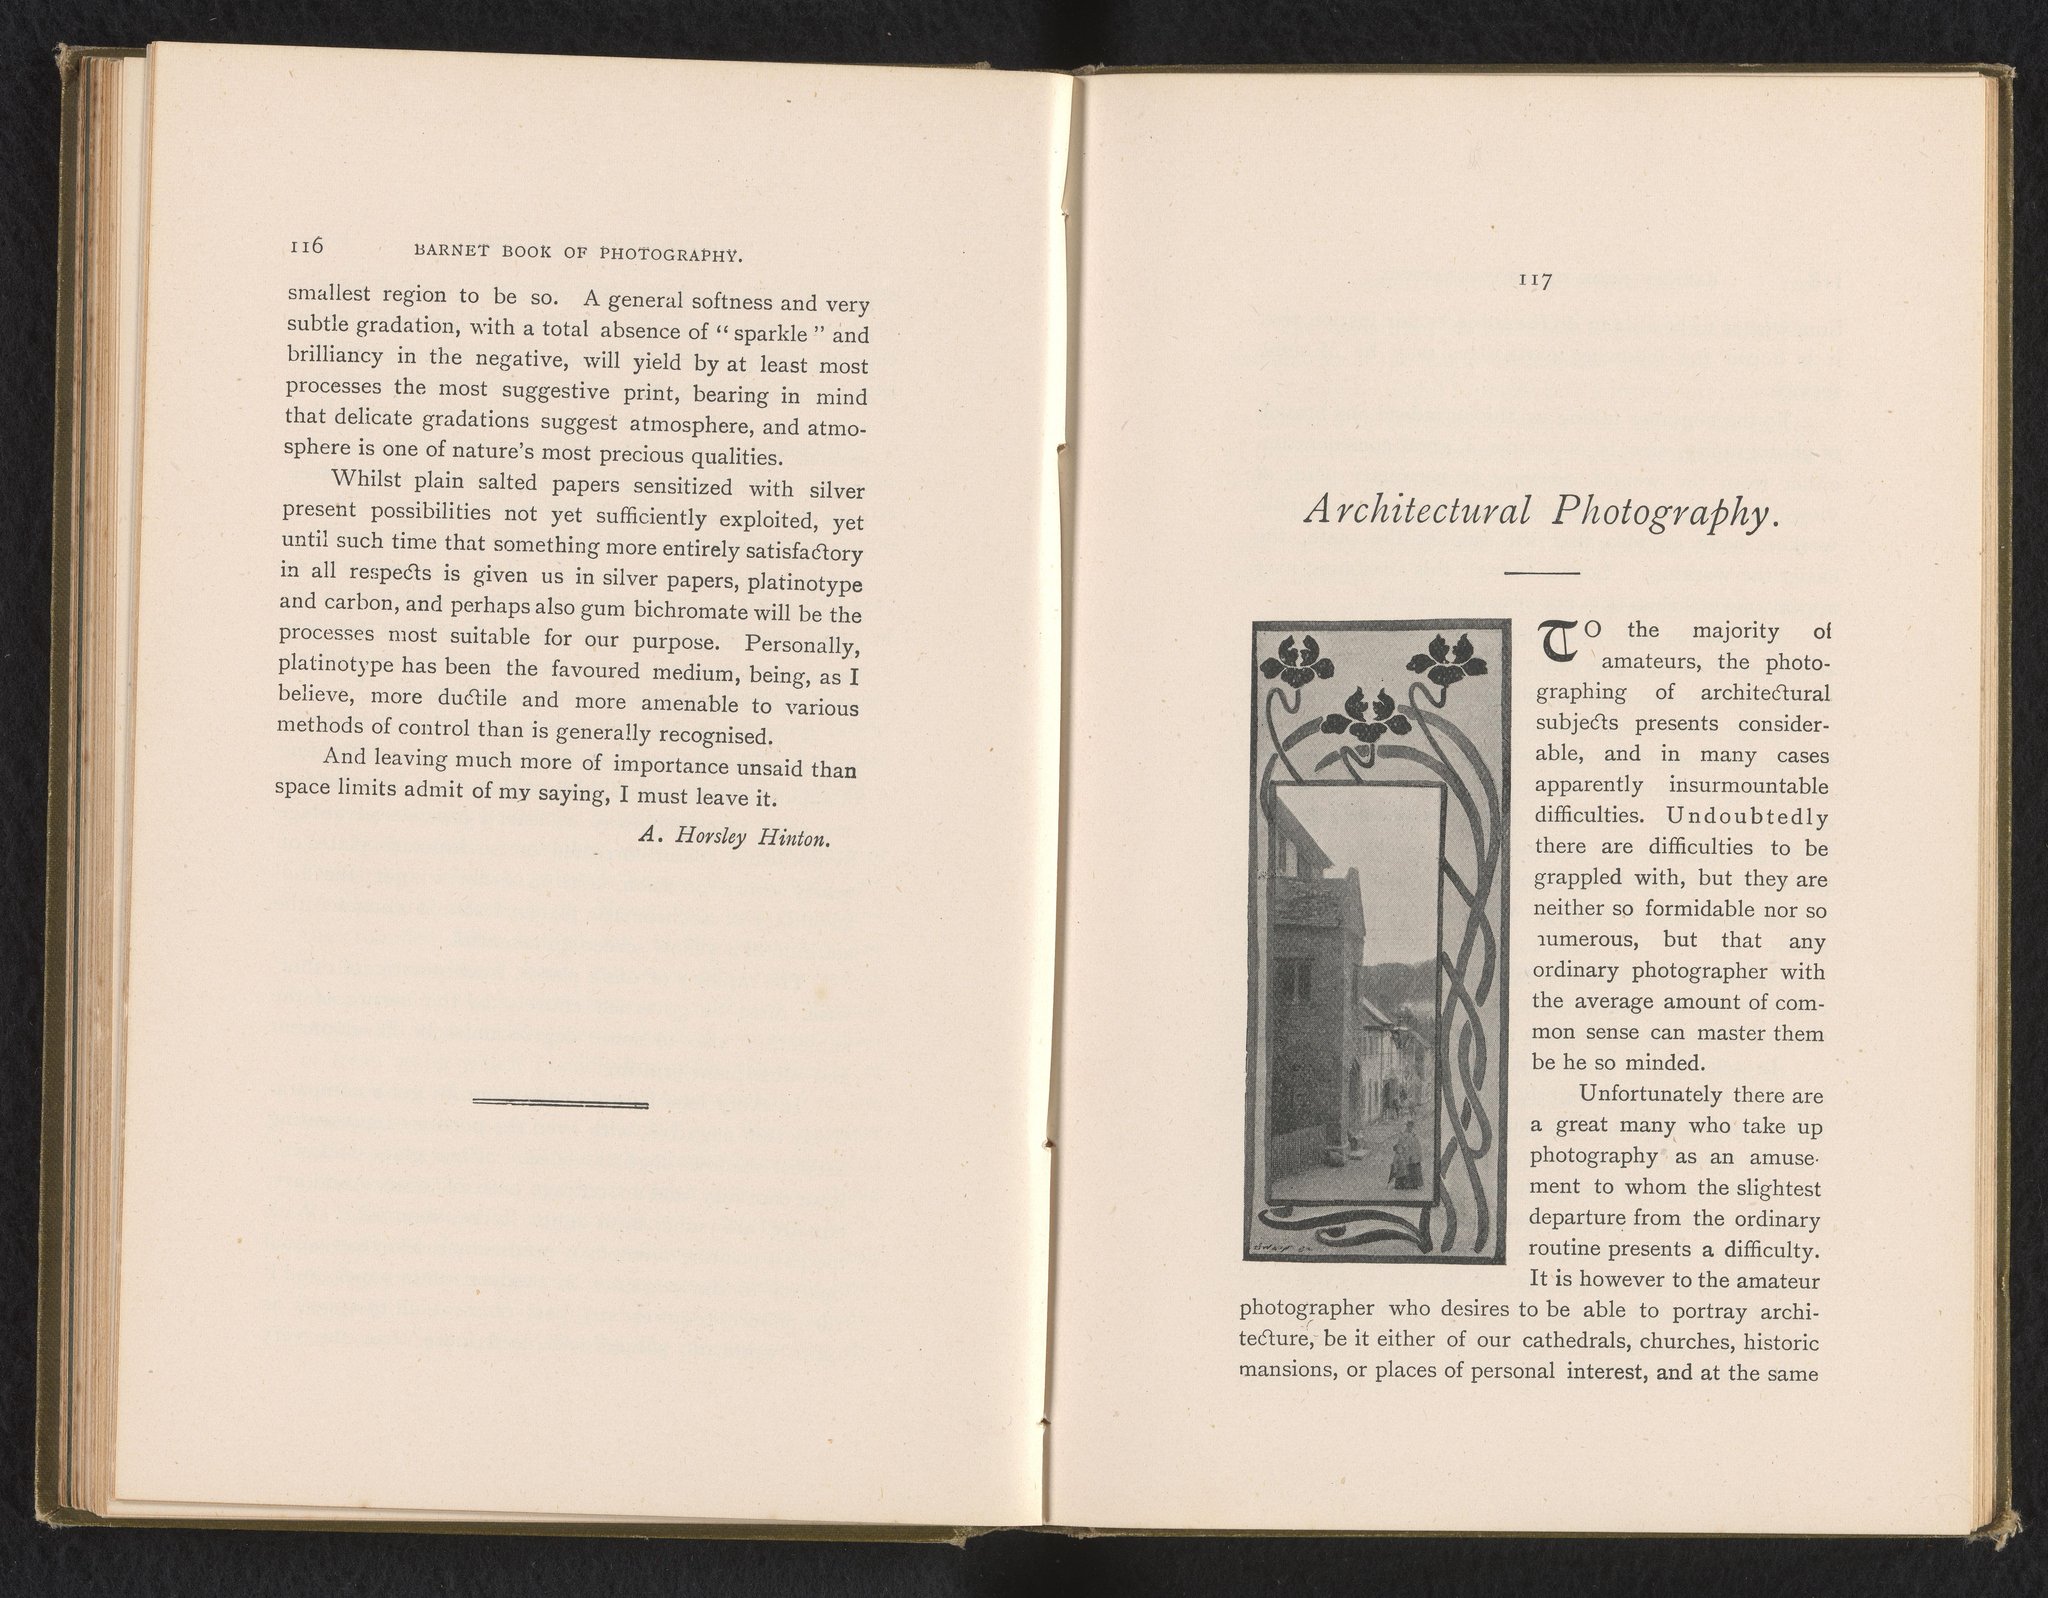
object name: page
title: Dorpsgezicht omlijst met irissen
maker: Anonymous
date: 1895-1900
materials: paper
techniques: letterpress printing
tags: flowers, village street